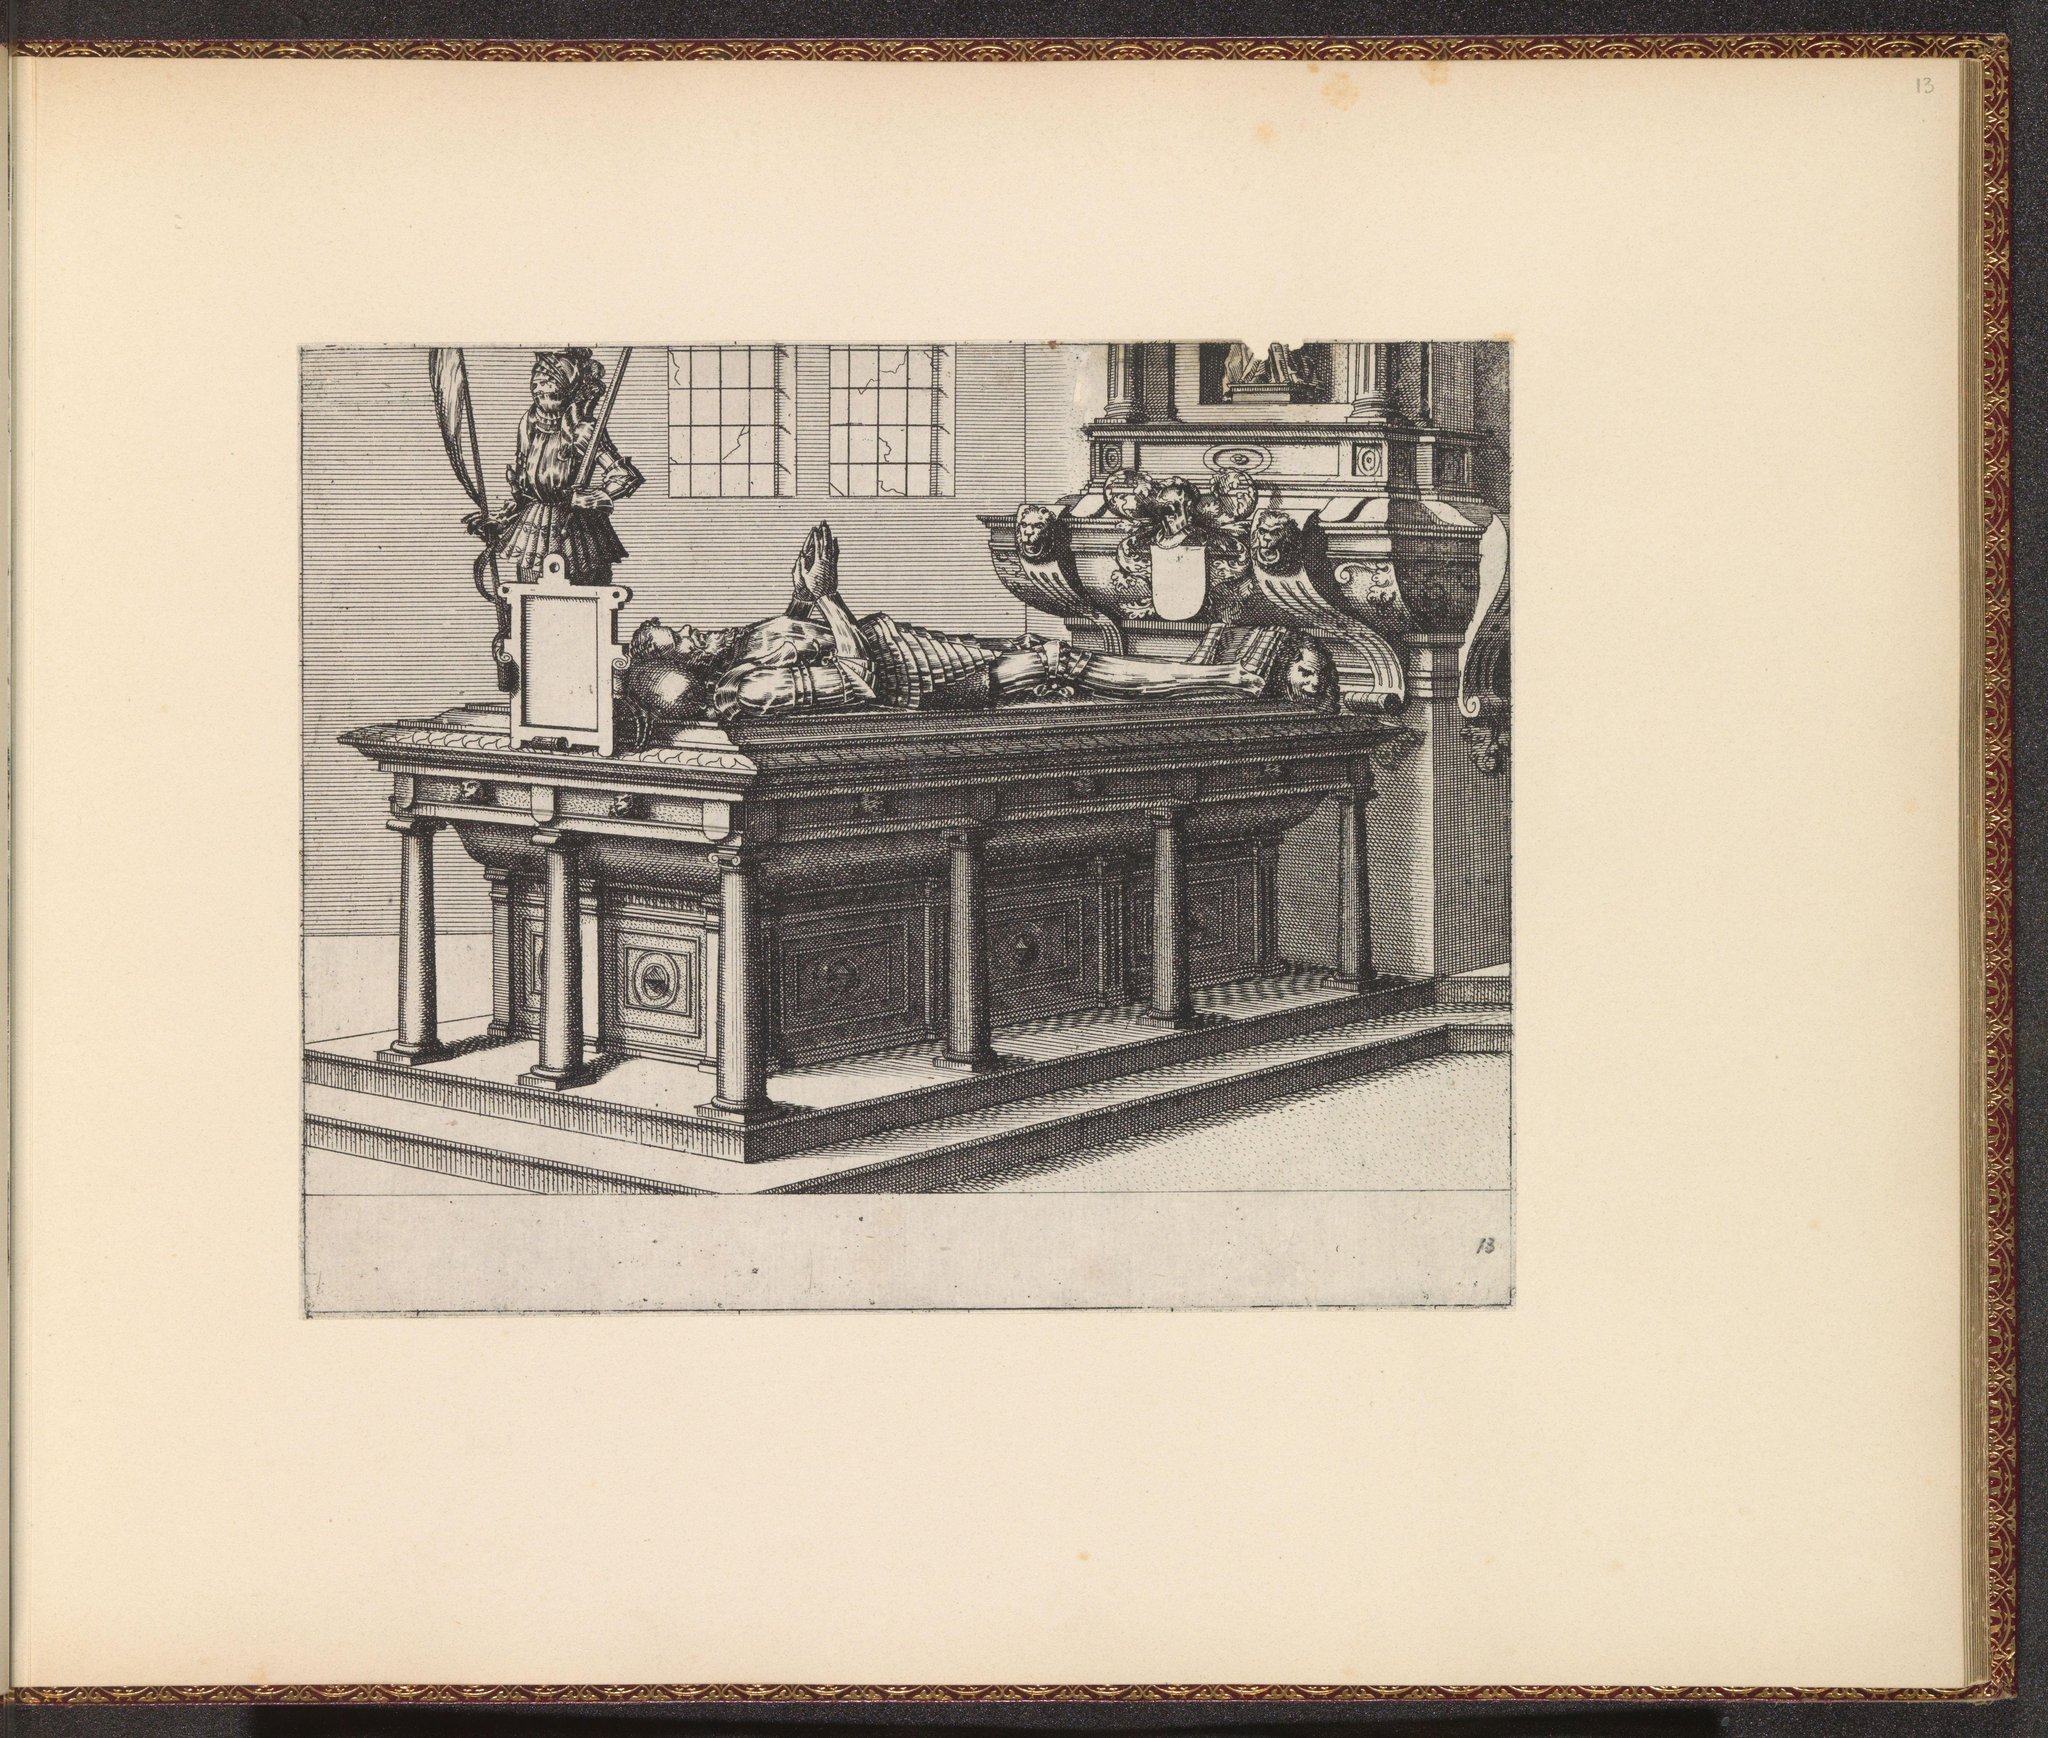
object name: ornament print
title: Grafmonument voor een man, met zuilen van de Ionische orde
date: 1563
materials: paper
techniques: etching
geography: antwerp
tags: effigy, 'gisant' (portrait-figure on closed coffin or in 'castrum doloris'), transi, ionic order ~ architecture, grave-building, monumental tomb, grave, tomb and other grave-forms and grave-markers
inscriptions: inscription: ‘13’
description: Grafmonument met de beeltenis van een geharnaste man (een gisant), geplaatst tegen de muur van een kapel. Aan het hoofdeinde een blanco plaquette geflankeerd door een krijgsman met vaandel en zwaard. Het voetstuk van de sarcograaf heeft zuilen van de Ionische orde. Zonder tekst in de ondermarge. De prent maakt deel uit van een album.